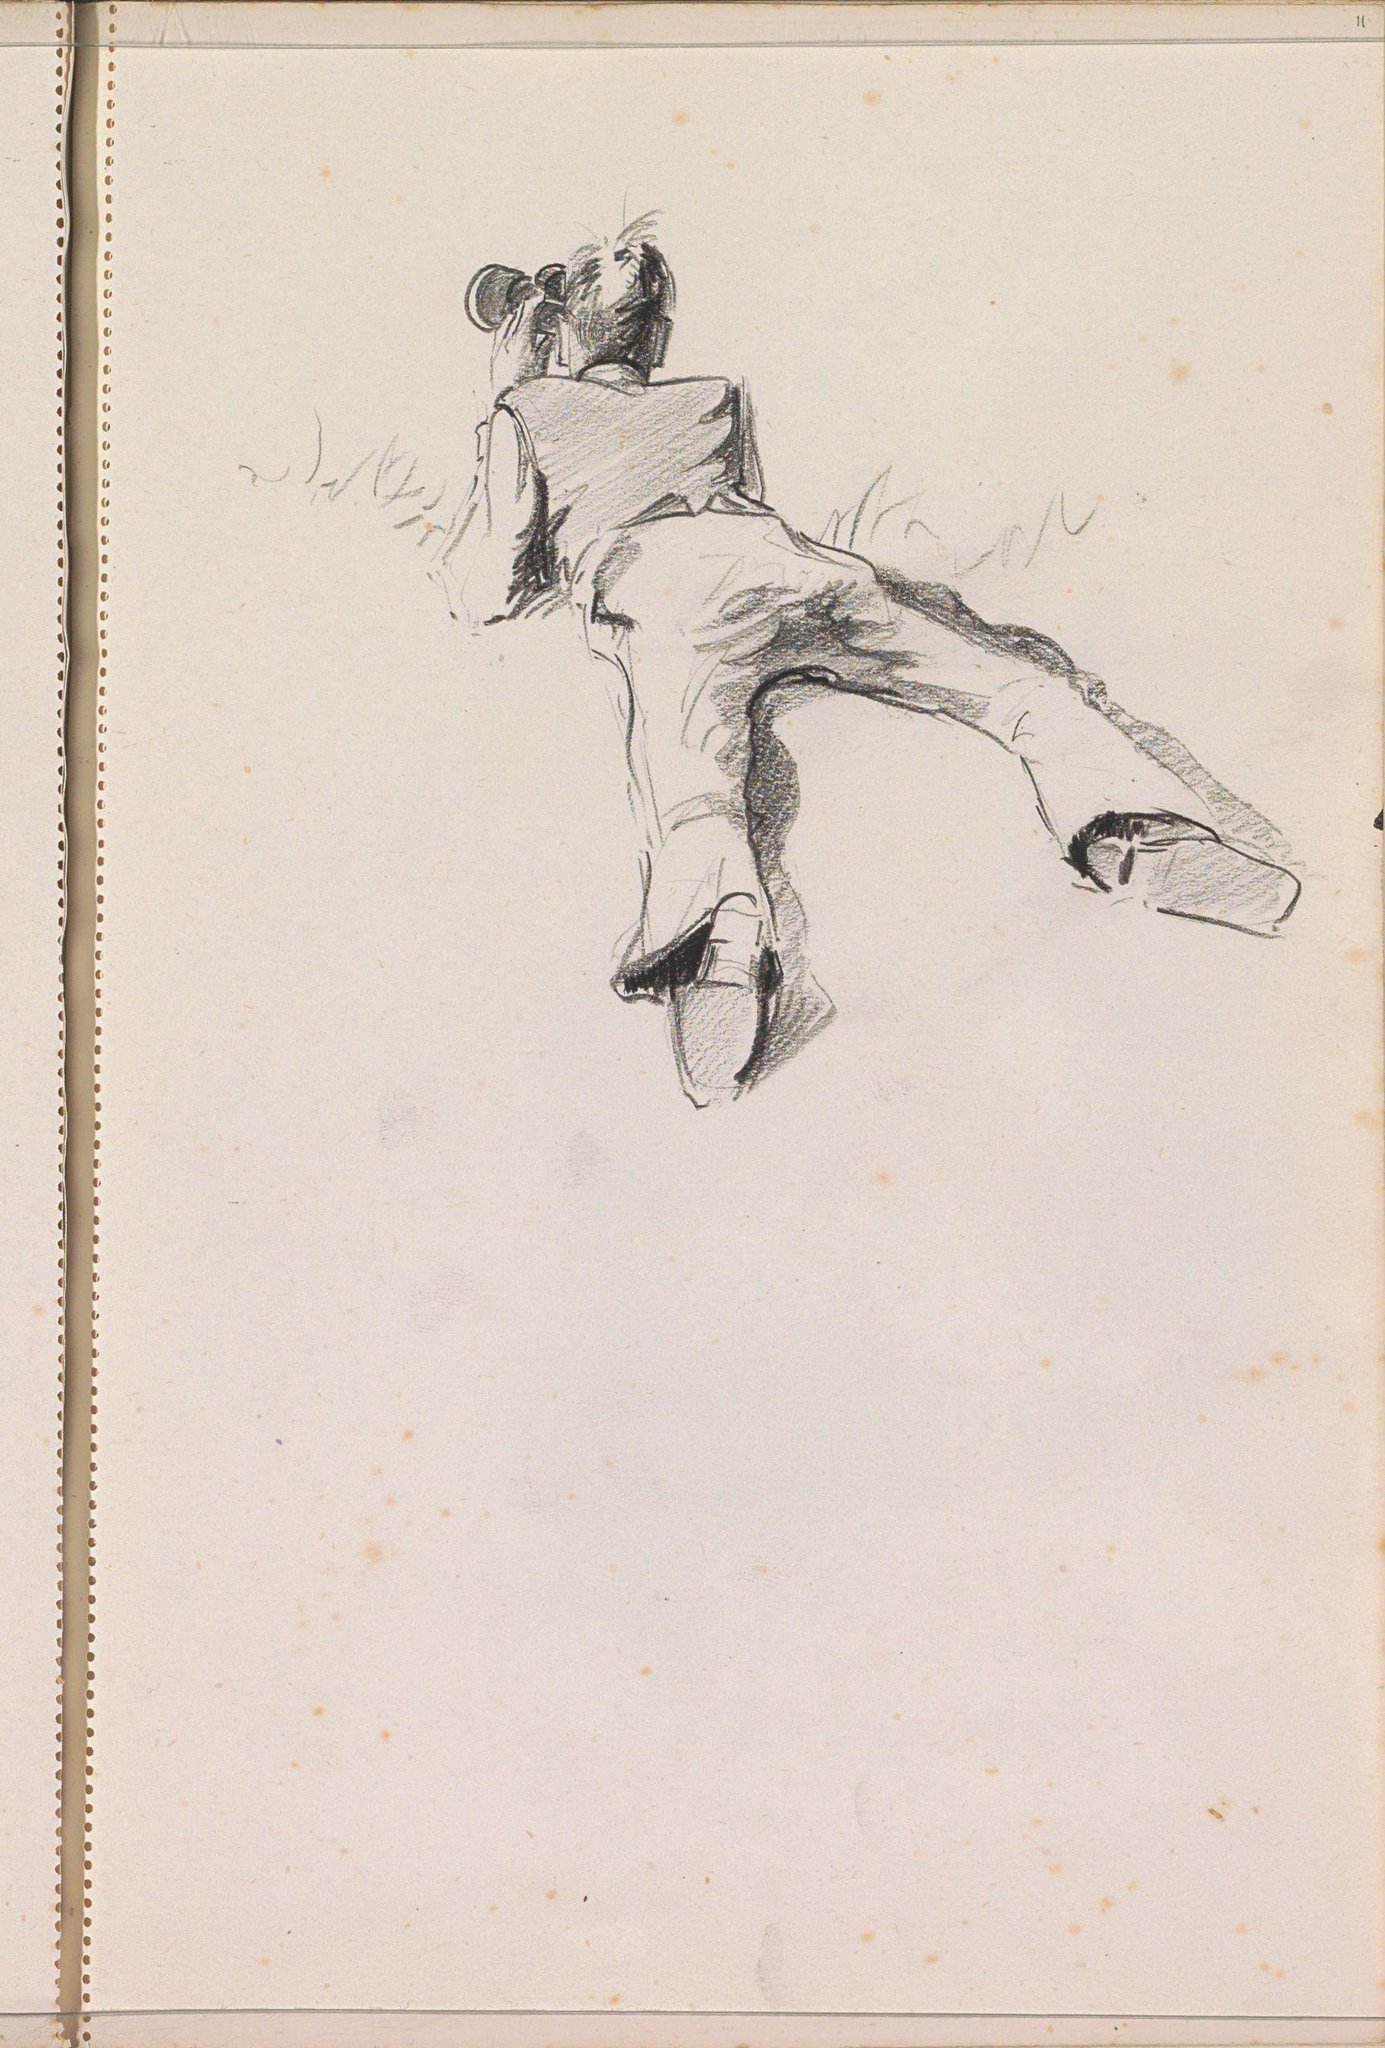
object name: sketchbook leaf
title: Liggende man in het gras met een verrekijker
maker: otto verhagen (i)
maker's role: draughtsman, print maker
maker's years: 1885-1951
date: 1922-1925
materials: chalk, paper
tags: lying figure, binoculars, spy-glass, etc.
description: Pagina 11 uit een schetsboek met 34 bladen.